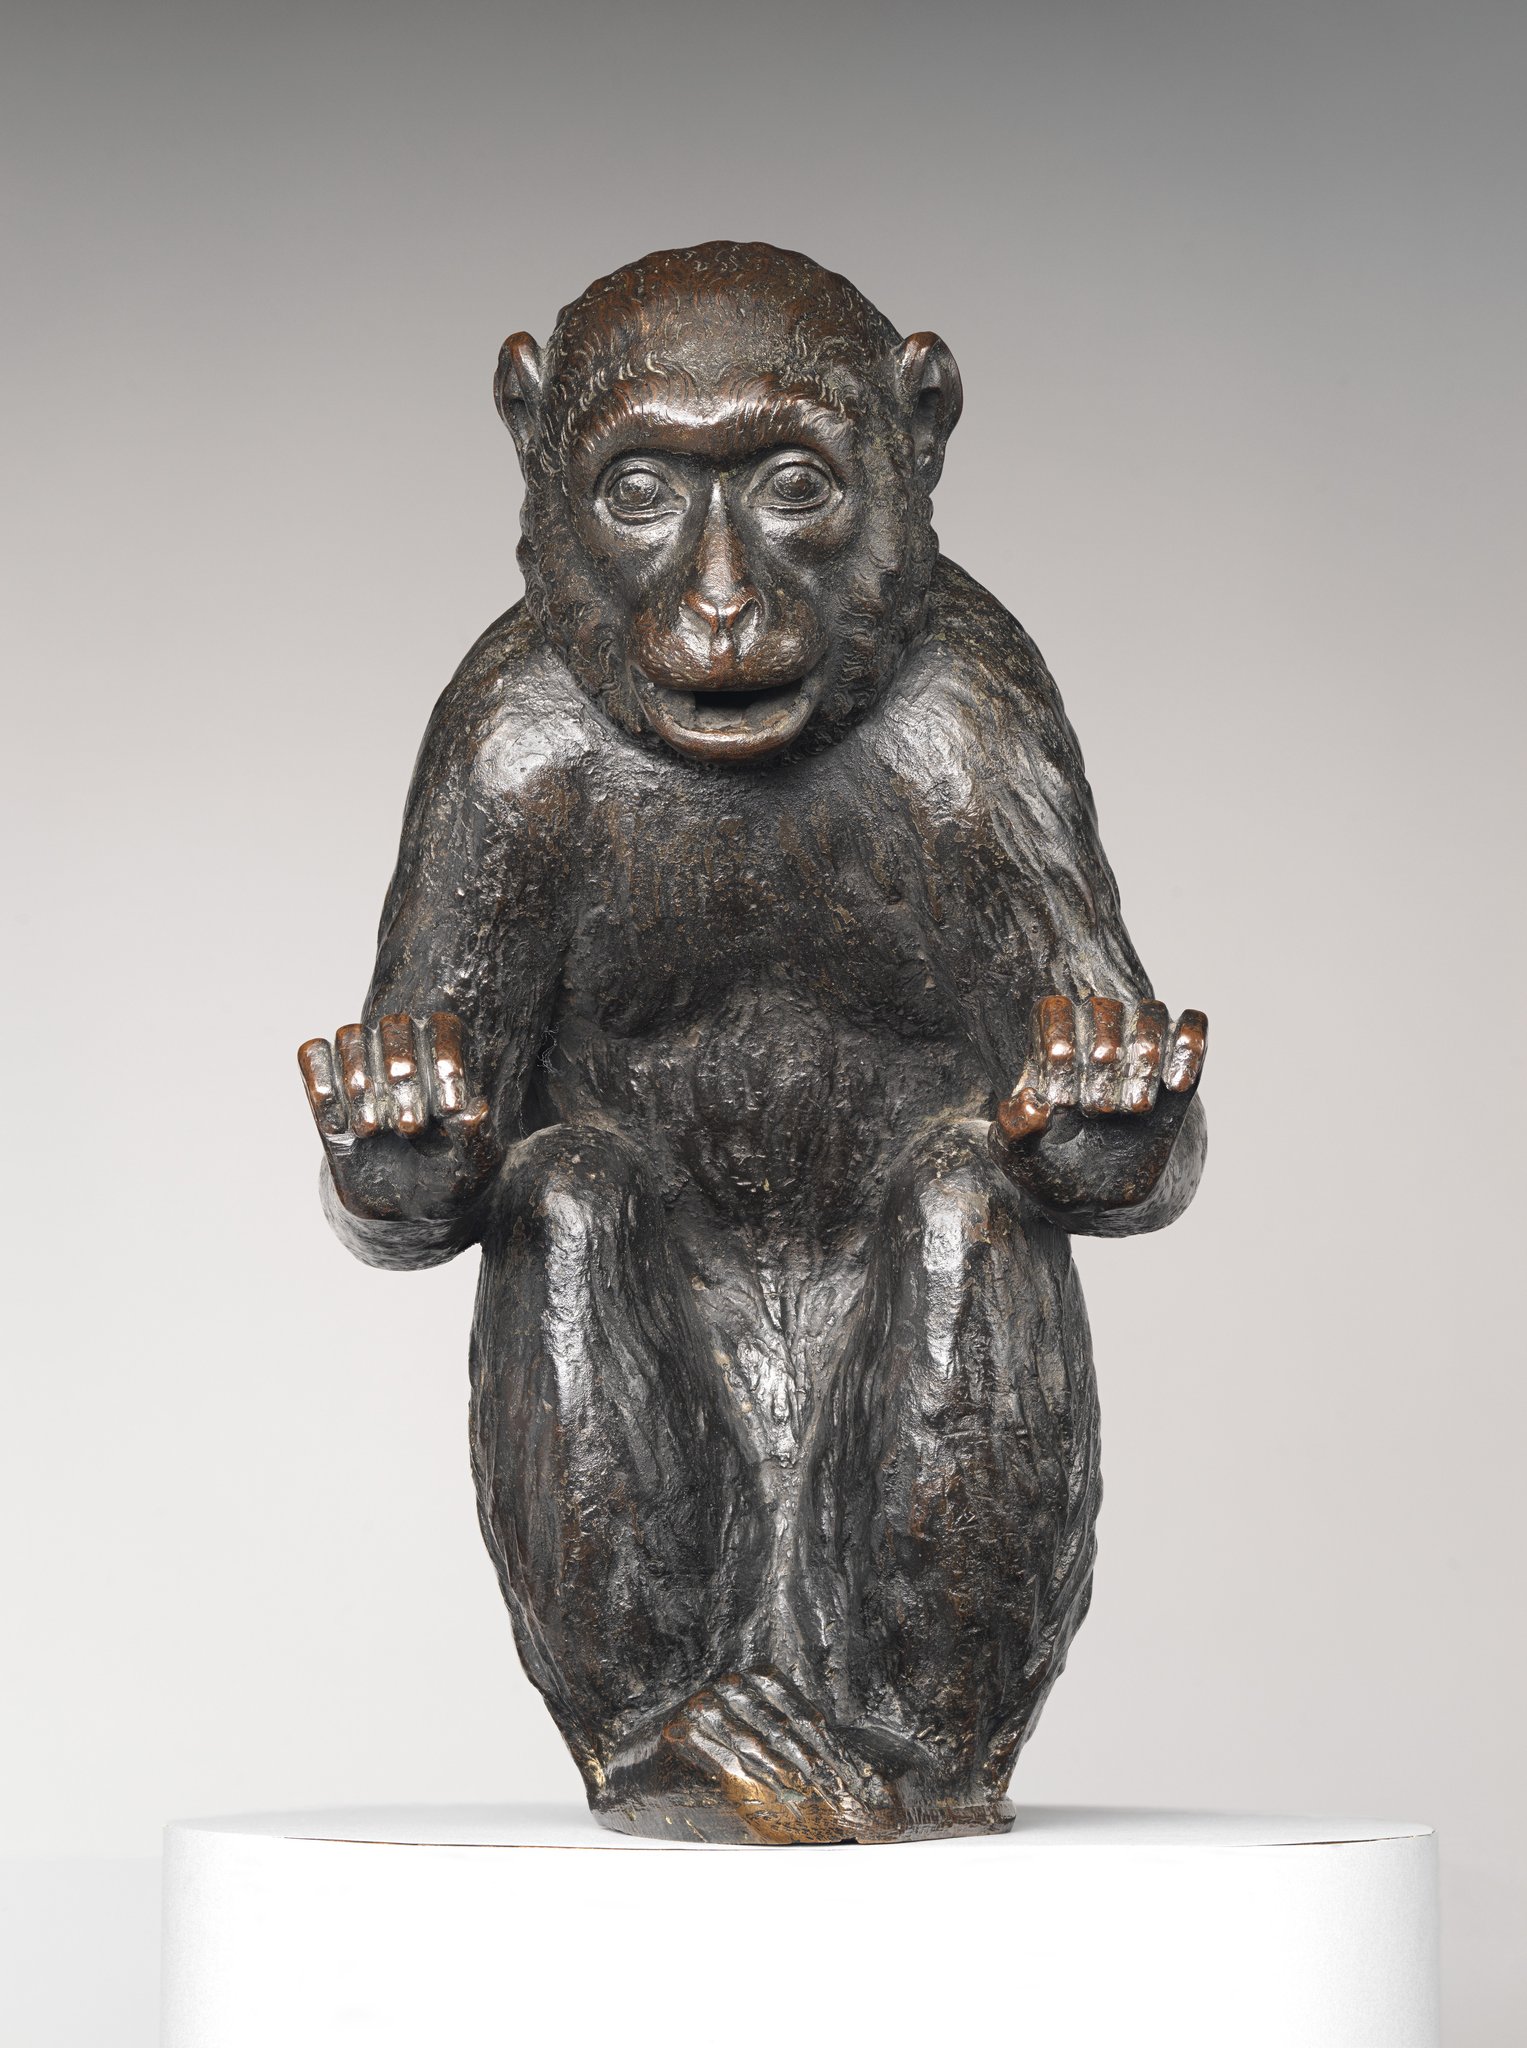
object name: fountain figure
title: Monkey fountain figure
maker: caspar gras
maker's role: modeler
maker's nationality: austrian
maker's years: 1585-1674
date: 1600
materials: bronze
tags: monkeys